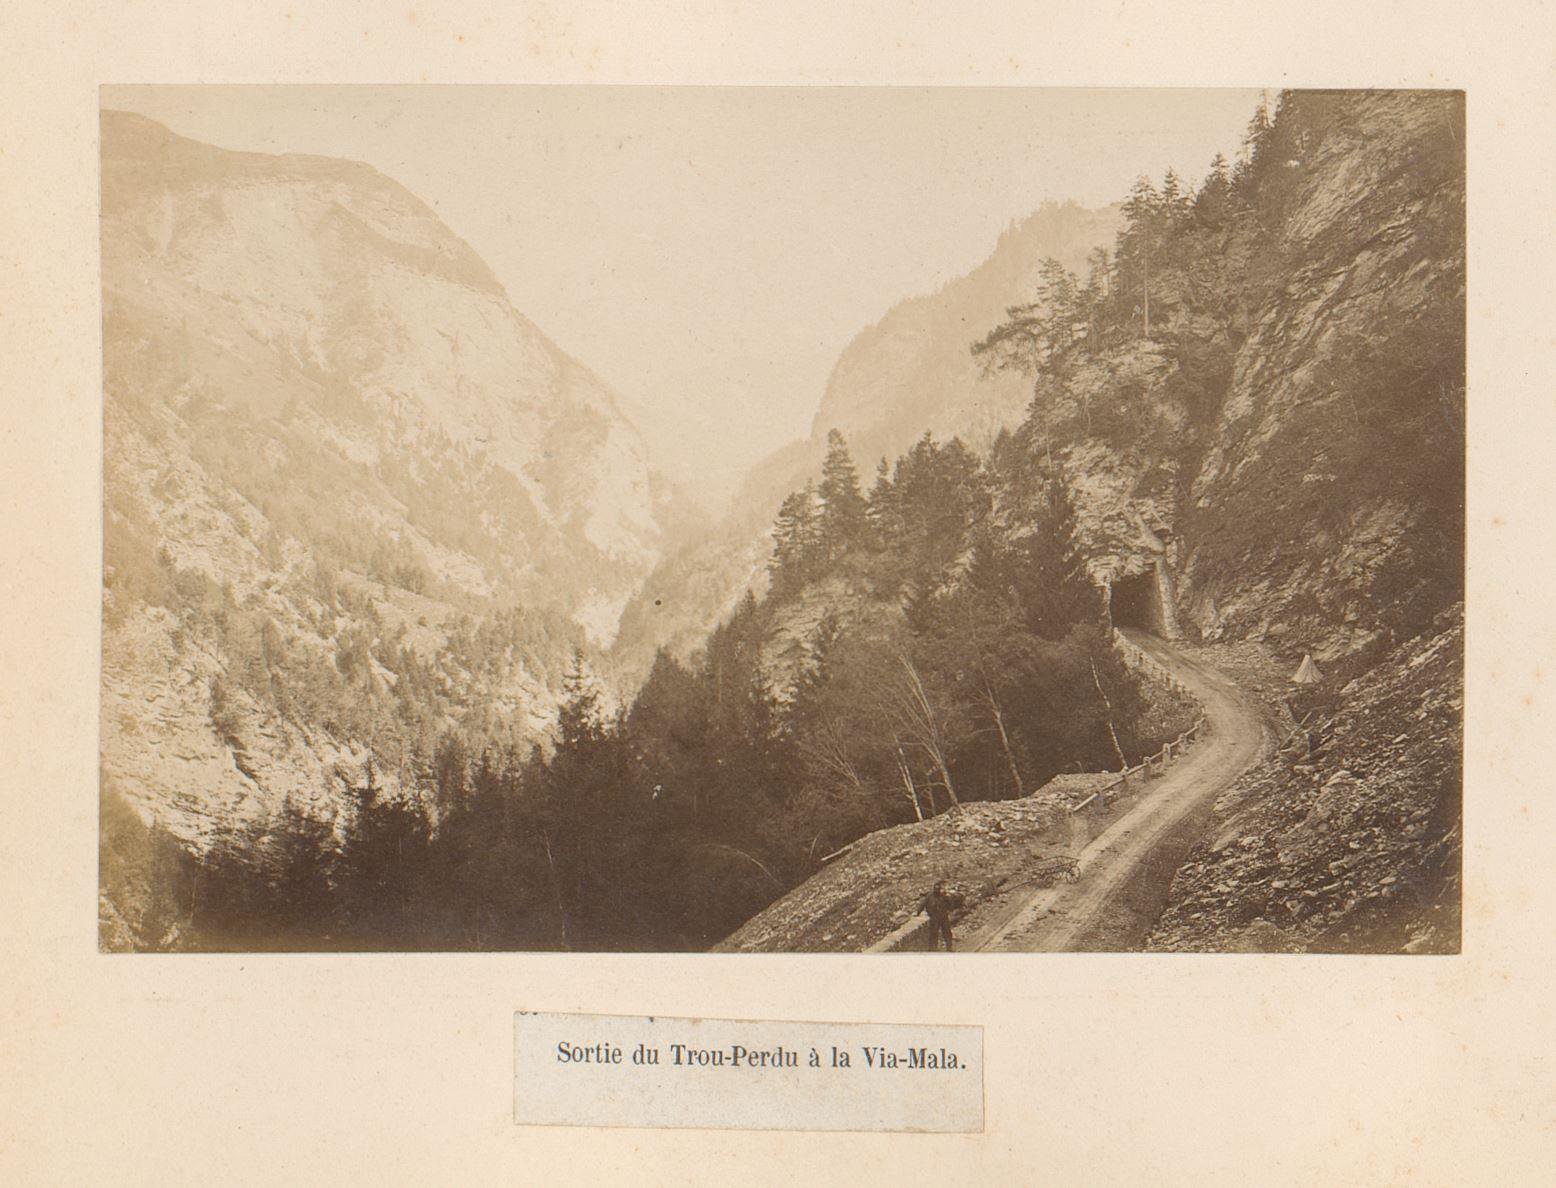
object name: album leaf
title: Sortie du Trou-Perdu à la Via-Mala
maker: Anonymous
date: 1860-1890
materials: paper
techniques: albumen print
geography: via mala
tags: ravine, chasm, abyss, canyon, underground road, tunnel, mountains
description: Vermoedelijk staat de afgebeelde persoon en diens tent ook op RP-F-F00997-AG.